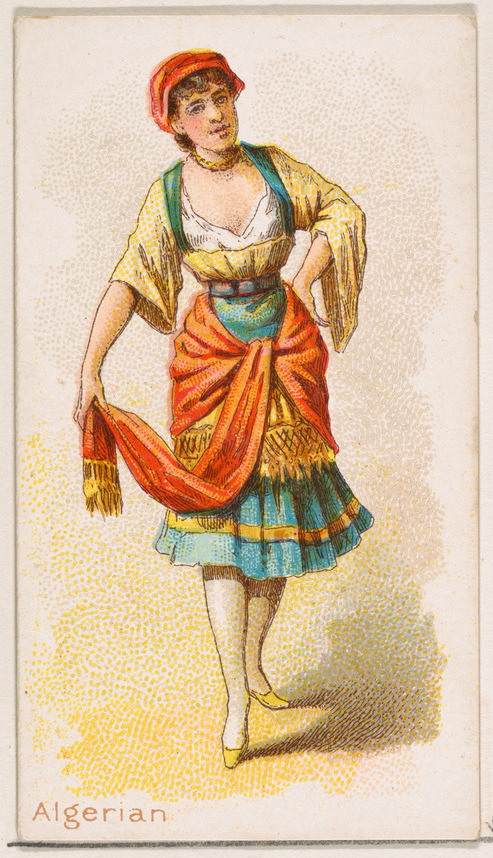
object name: print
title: Algerian Dancer, from the Dancing Women series (N186) issued by Wm. S. Kimball & Co.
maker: william s. kimball & company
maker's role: publisher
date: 1889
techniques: color lithograph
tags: dance,women,dancers